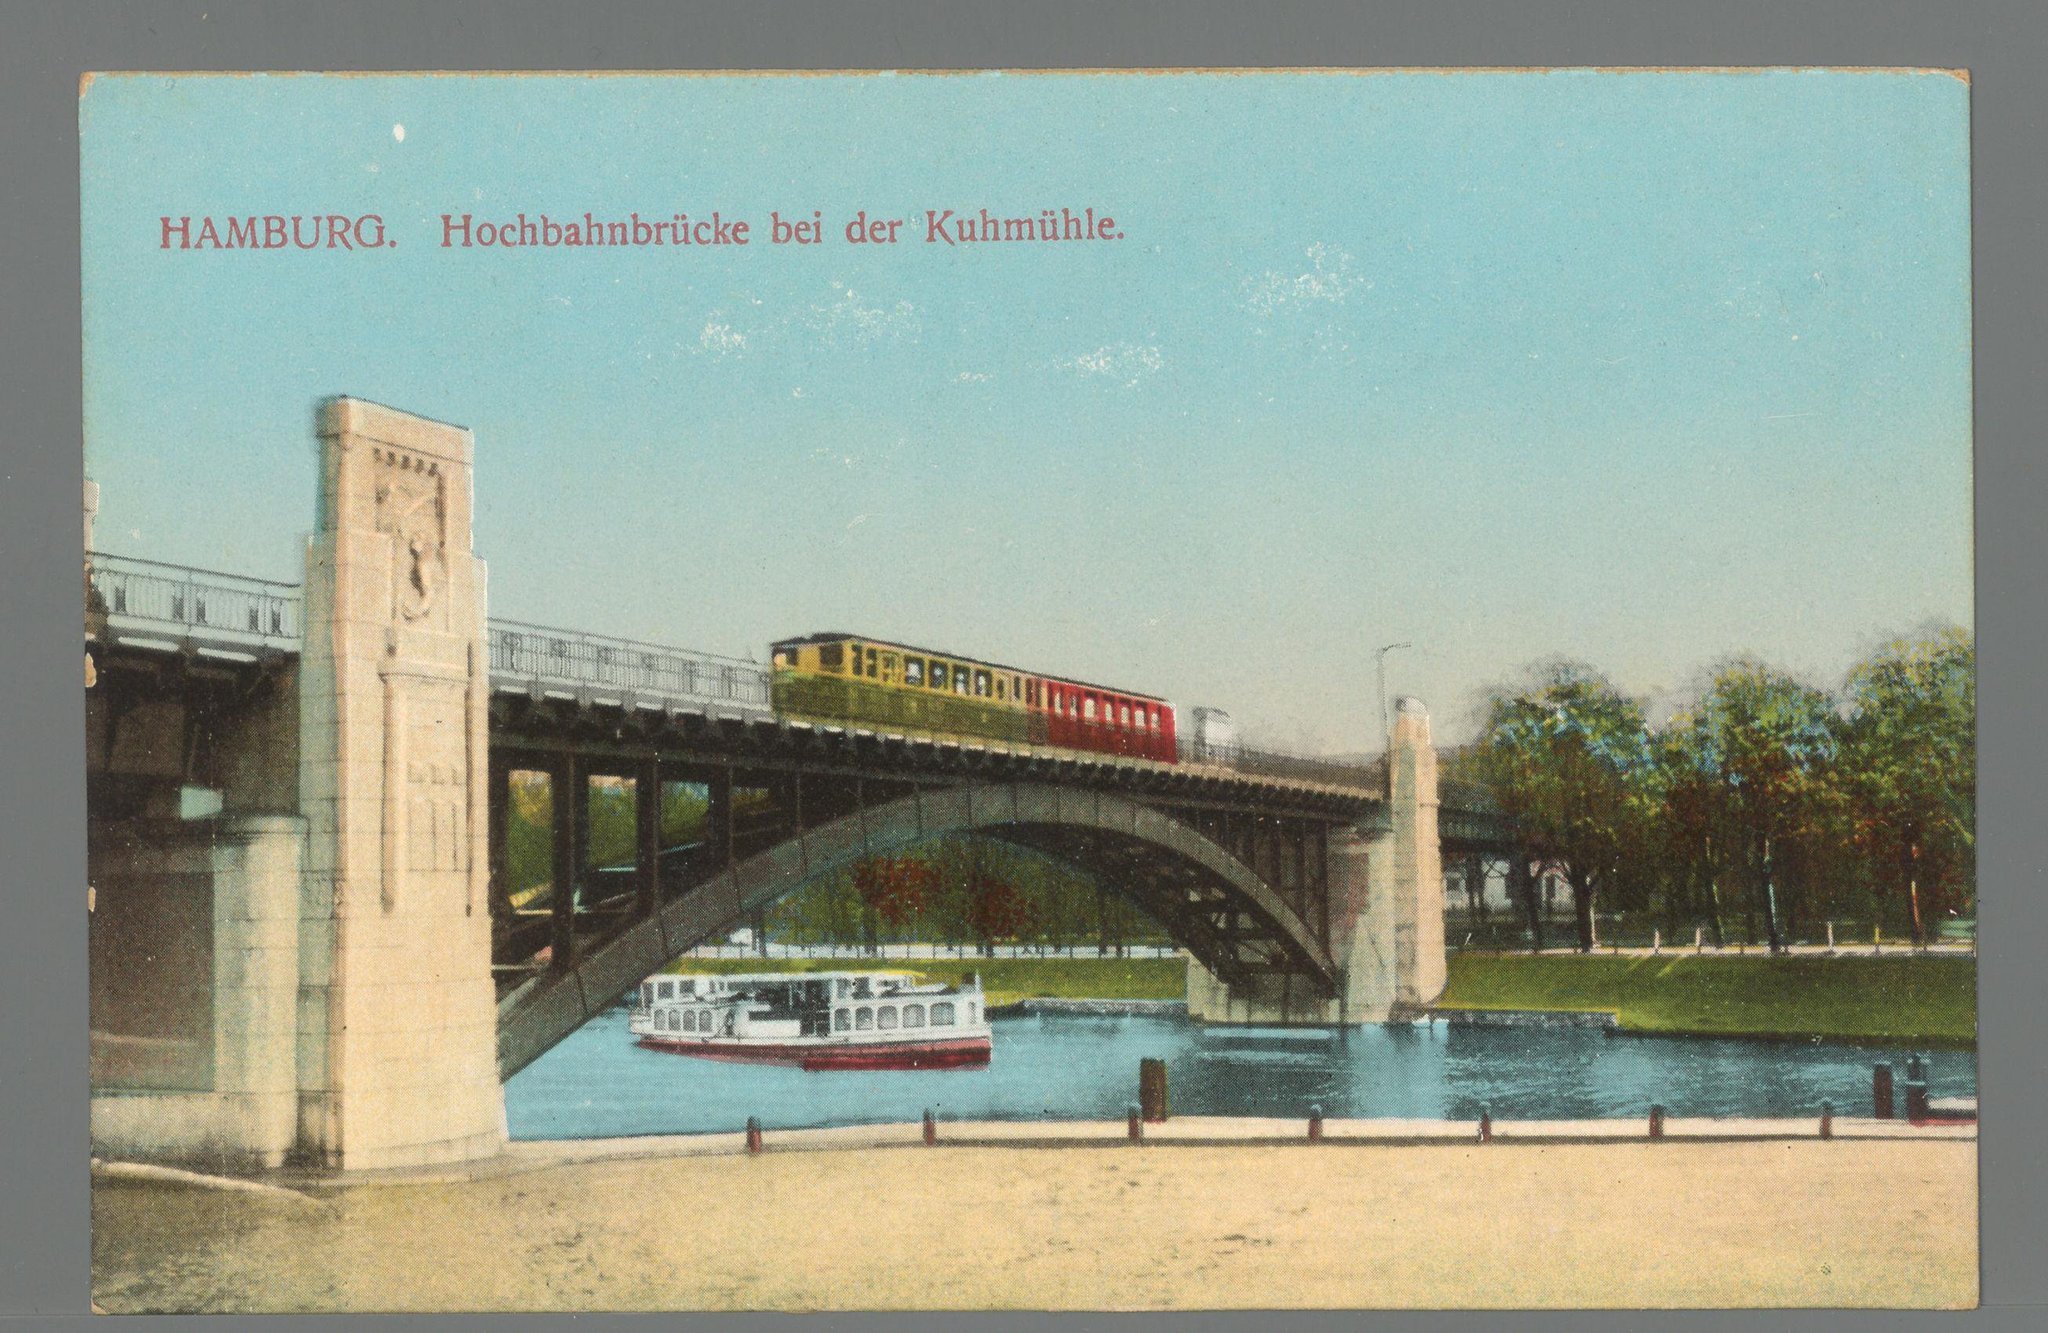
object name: ansichtkaart, prentbriefkaart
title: Hamburg. Hochbahnbrücke bei der Kuhmühle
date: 1905-1930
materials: cardboard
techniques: lithograph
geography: hamburg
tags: canals, waters (in city), railway, train, bridge in city across river, canal, etc.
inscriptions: monogram: ‘H.H.H.’